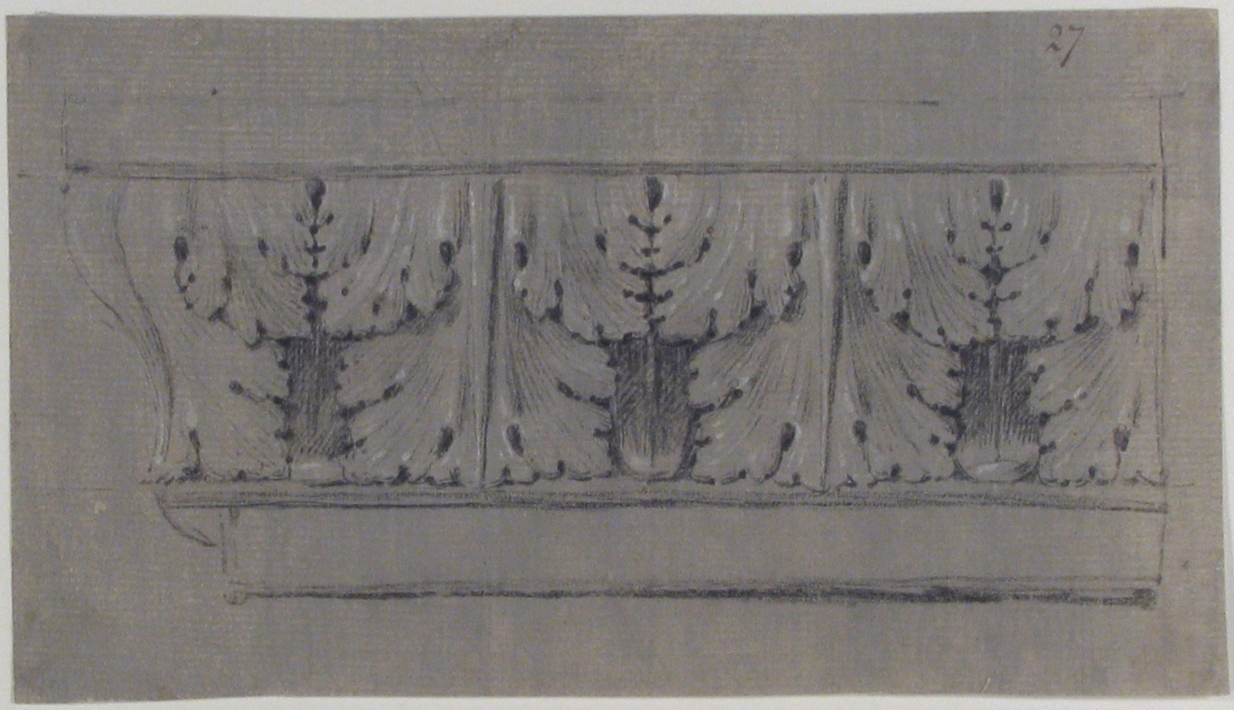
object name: drawing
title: Design for a Cornice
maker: anonymous, french, 19th century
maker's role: artist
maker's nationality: french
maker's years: 1800-1900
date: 1825-1850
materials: chalk, graphite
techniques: heightening